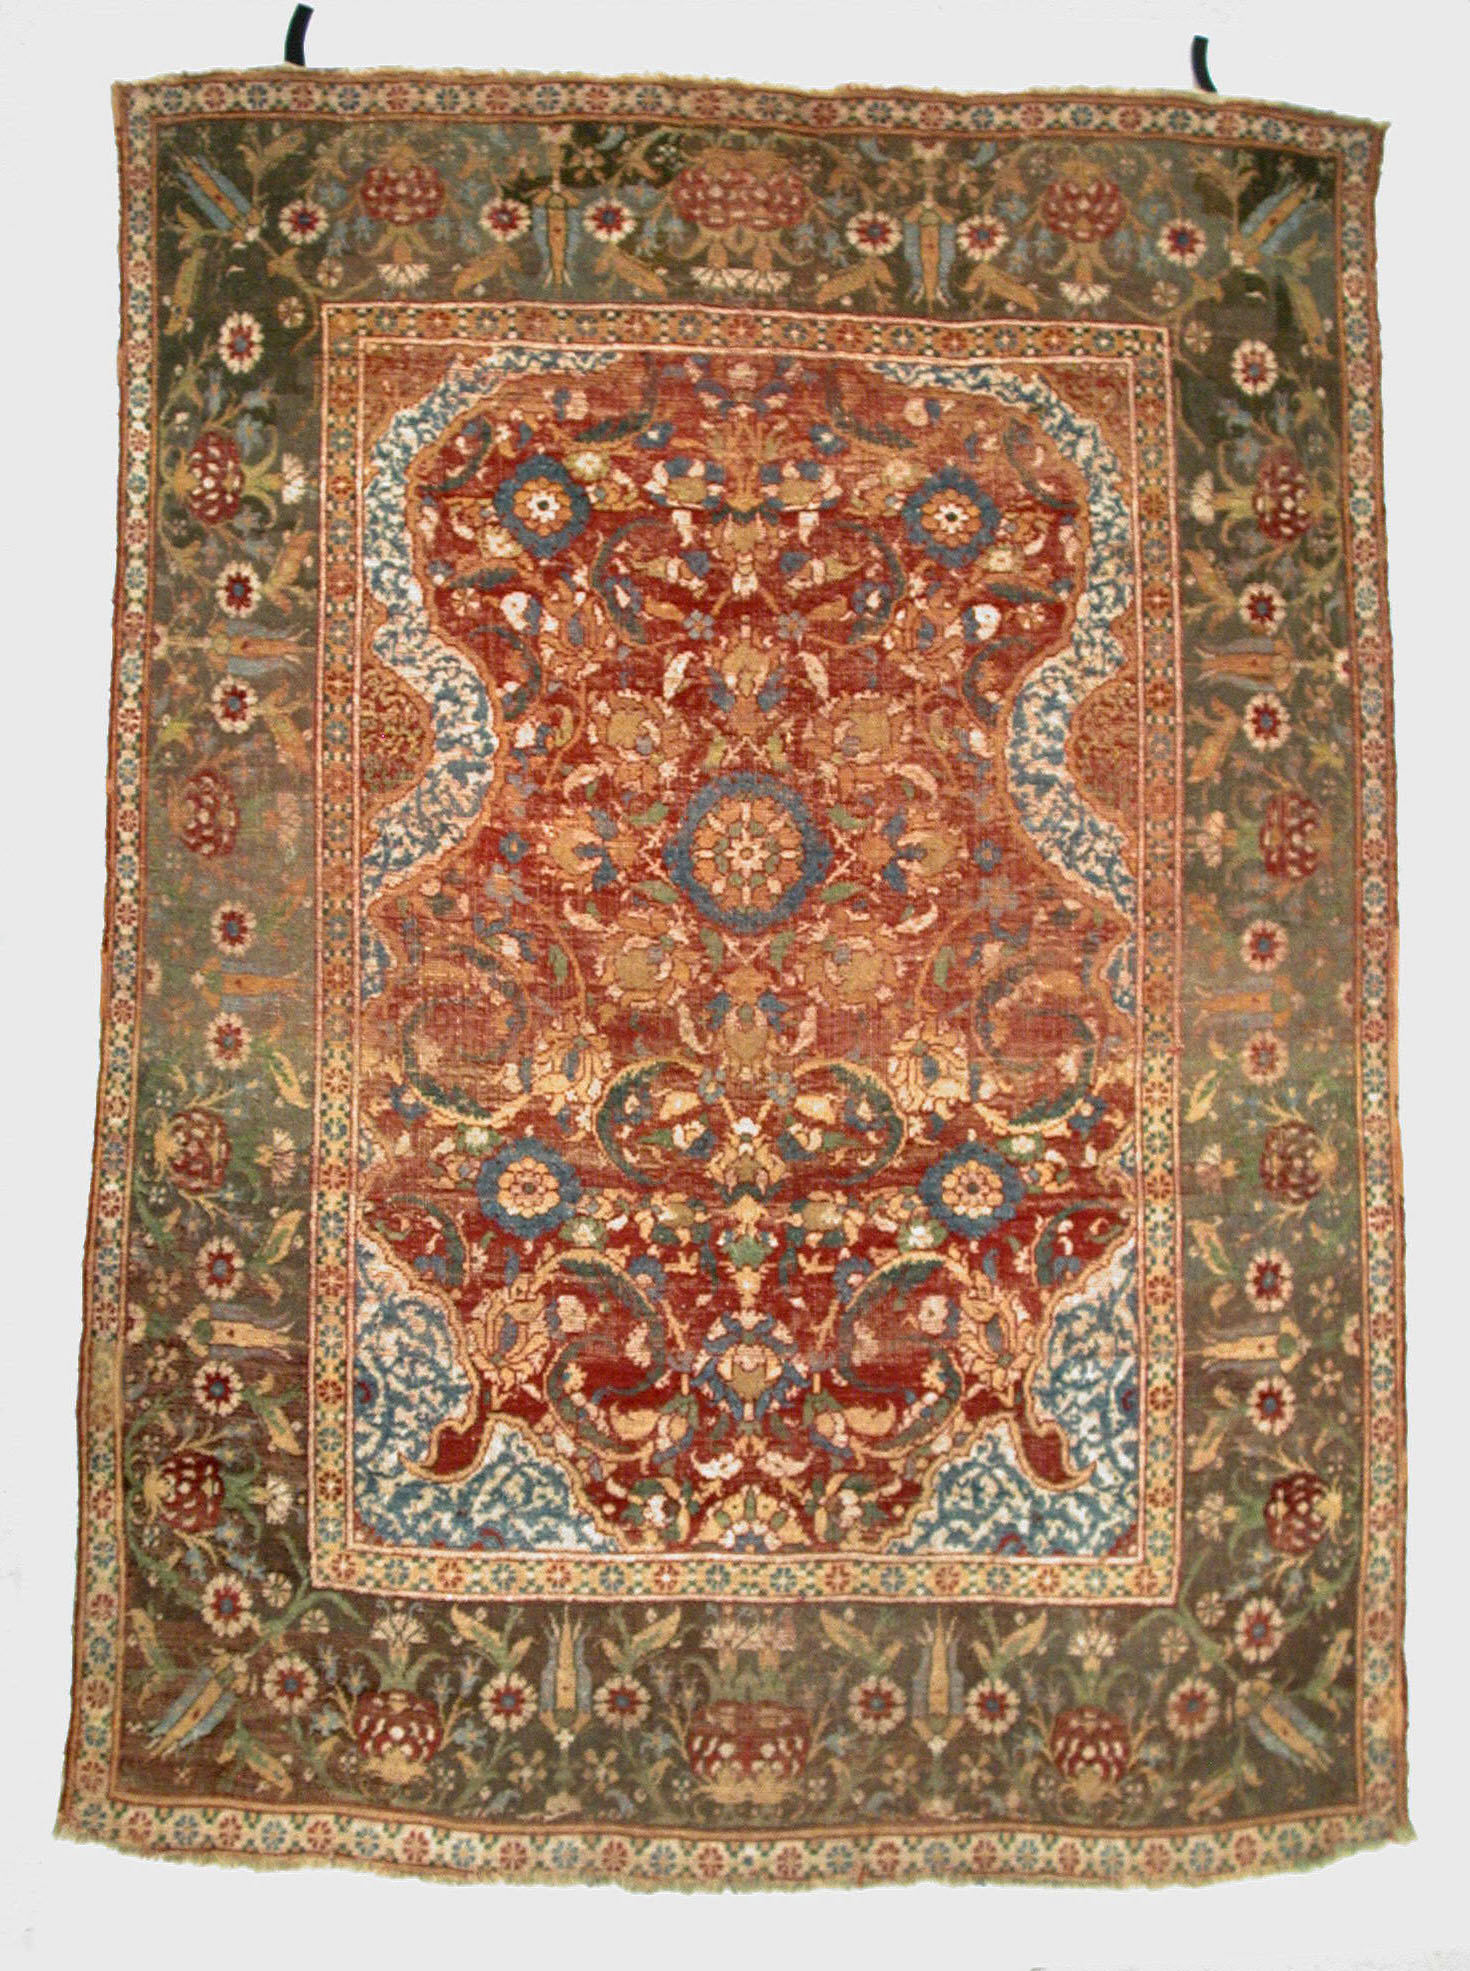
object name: carpet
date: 1601-1700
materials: wool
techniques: asymmetrically knotted pile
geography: egypt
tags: flowers